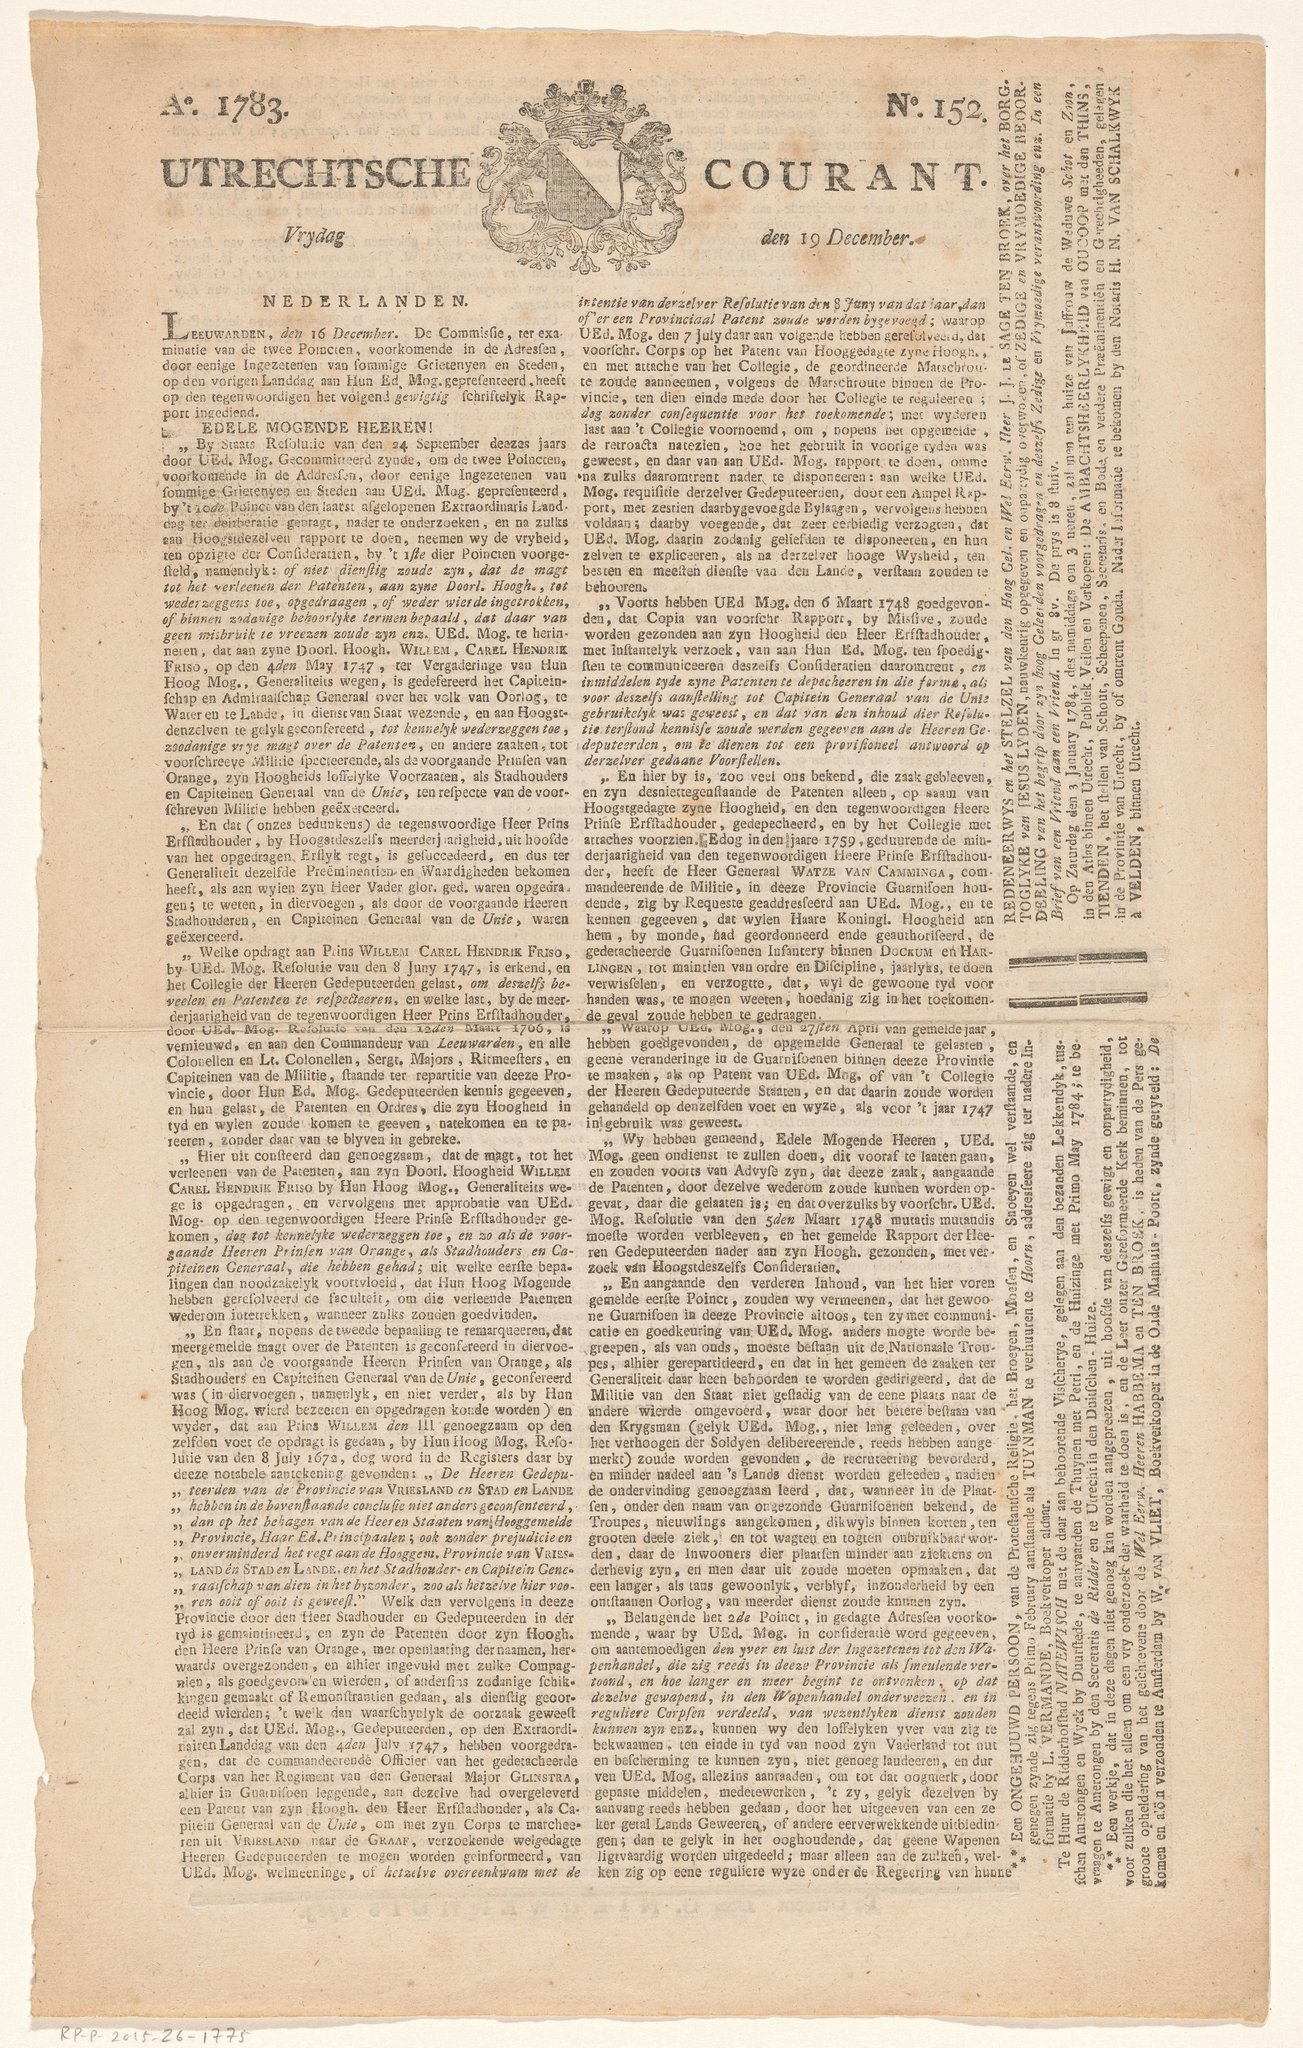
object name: newspaper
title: Aflevering van de Utrechtsche Courant, 19 december 1783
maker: g. nieuwenhuis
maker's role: publisher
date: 1783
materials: paper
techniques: letterpress printing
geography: utrecht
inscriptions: collector's mark: Lugt 2228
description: Op verso een advertentie van Martinus de Bruyn, boekhandelaar te Amsterdam.